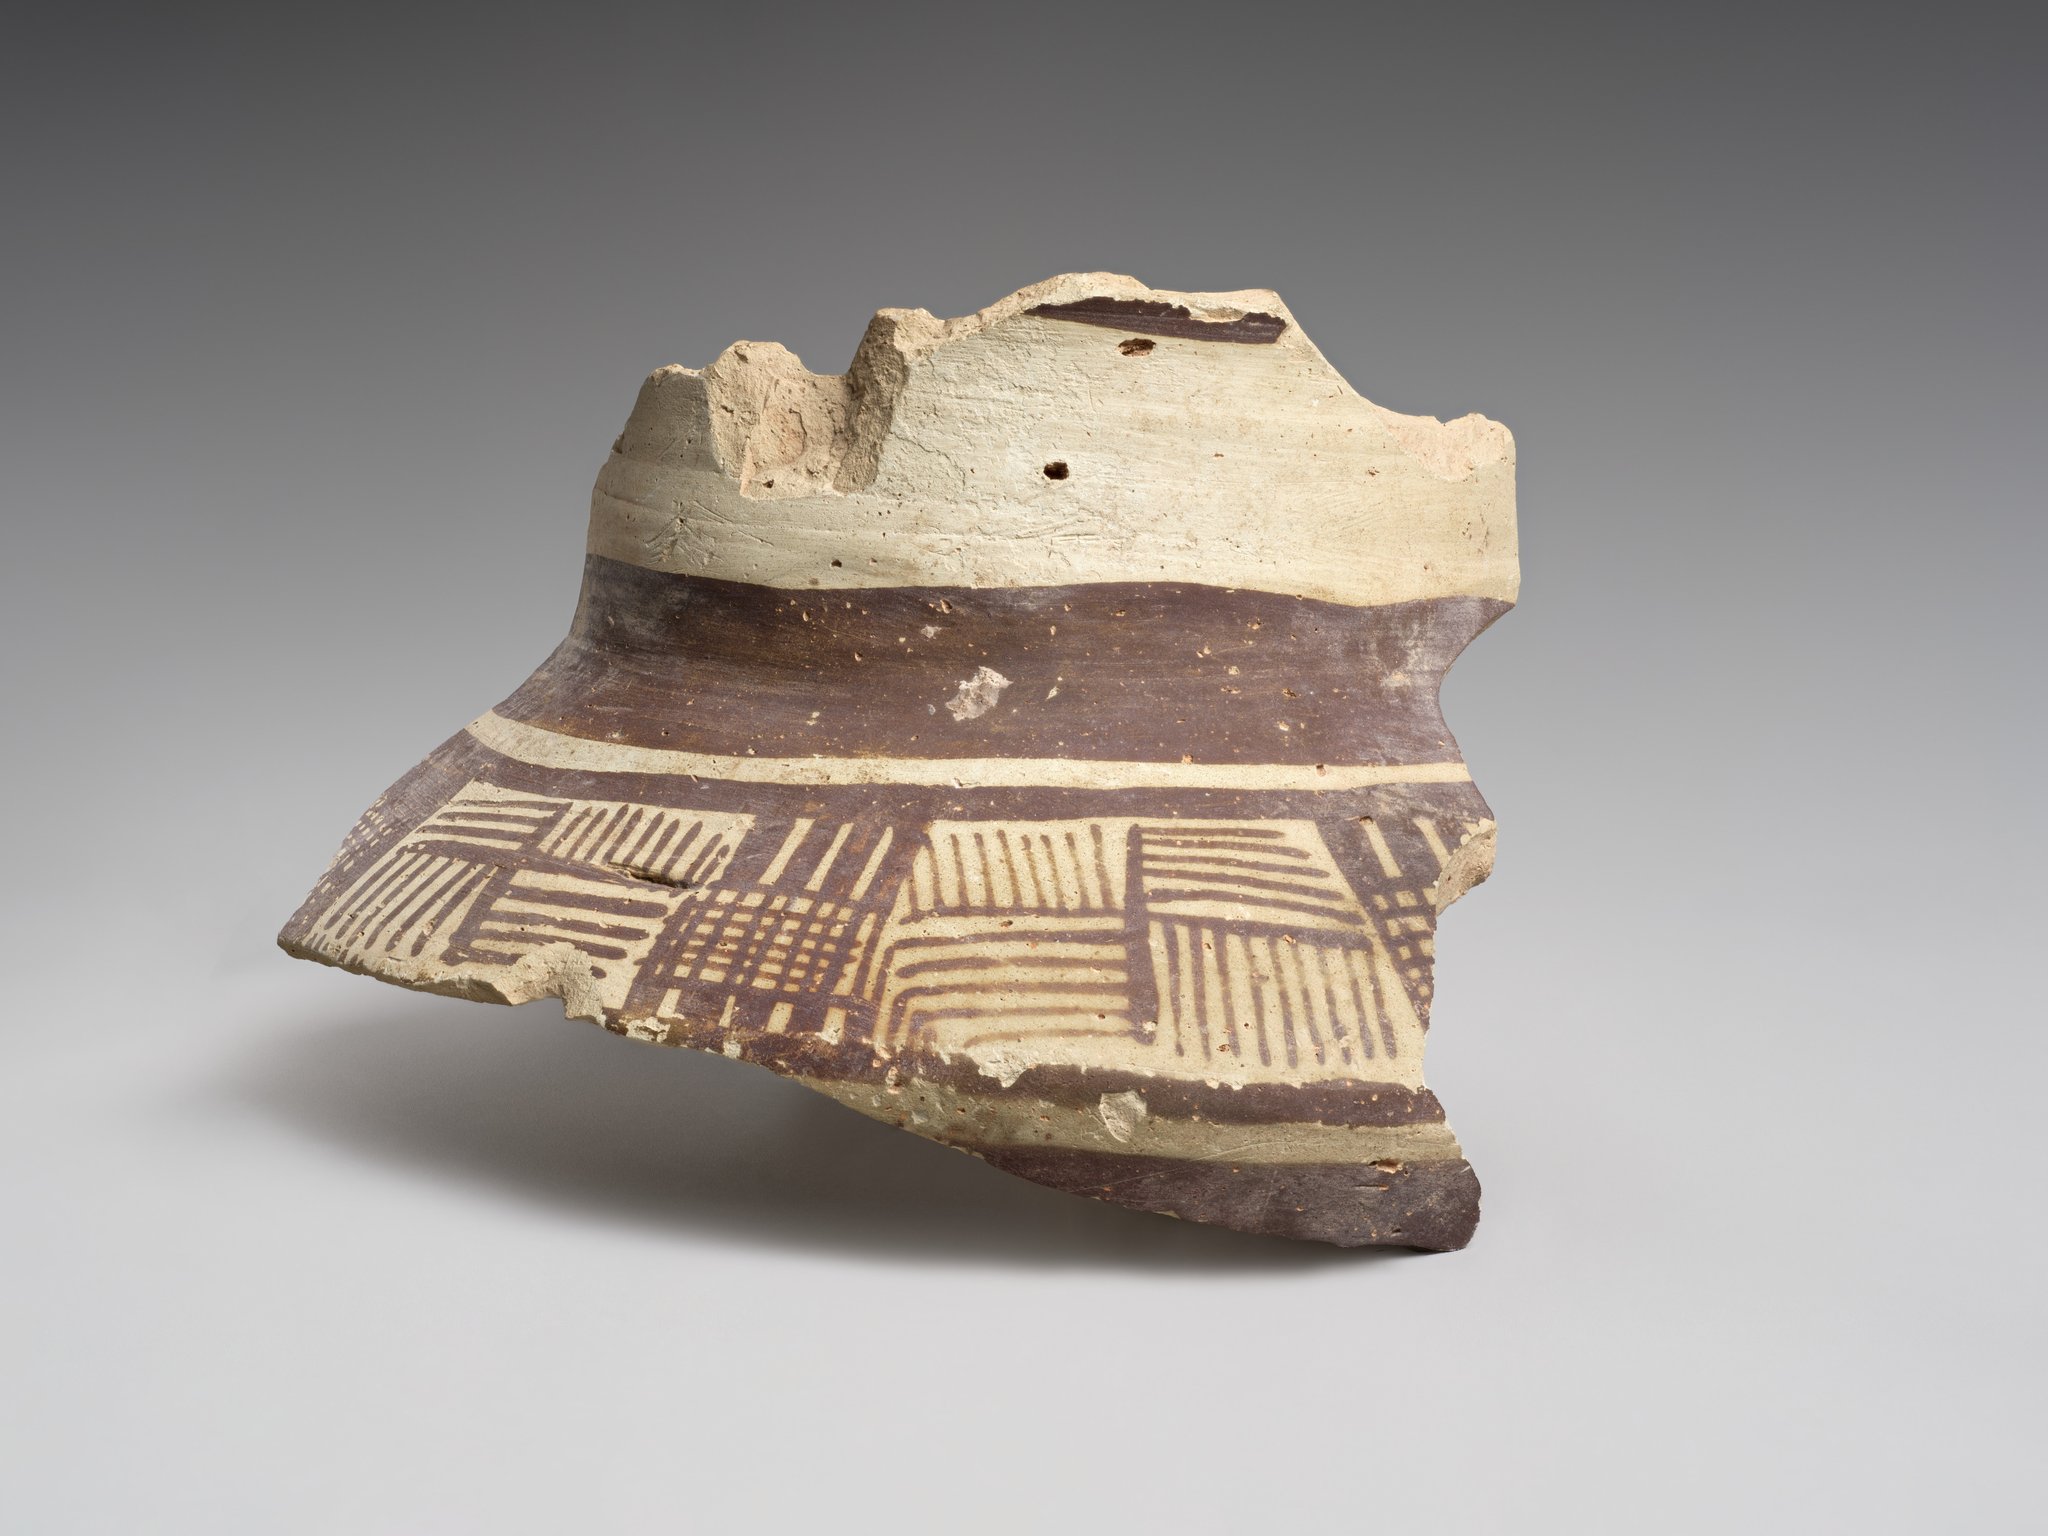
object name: jar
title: Jar sherd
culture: iranian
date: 4000-3001 BCE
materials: ceramic, paint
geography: iran